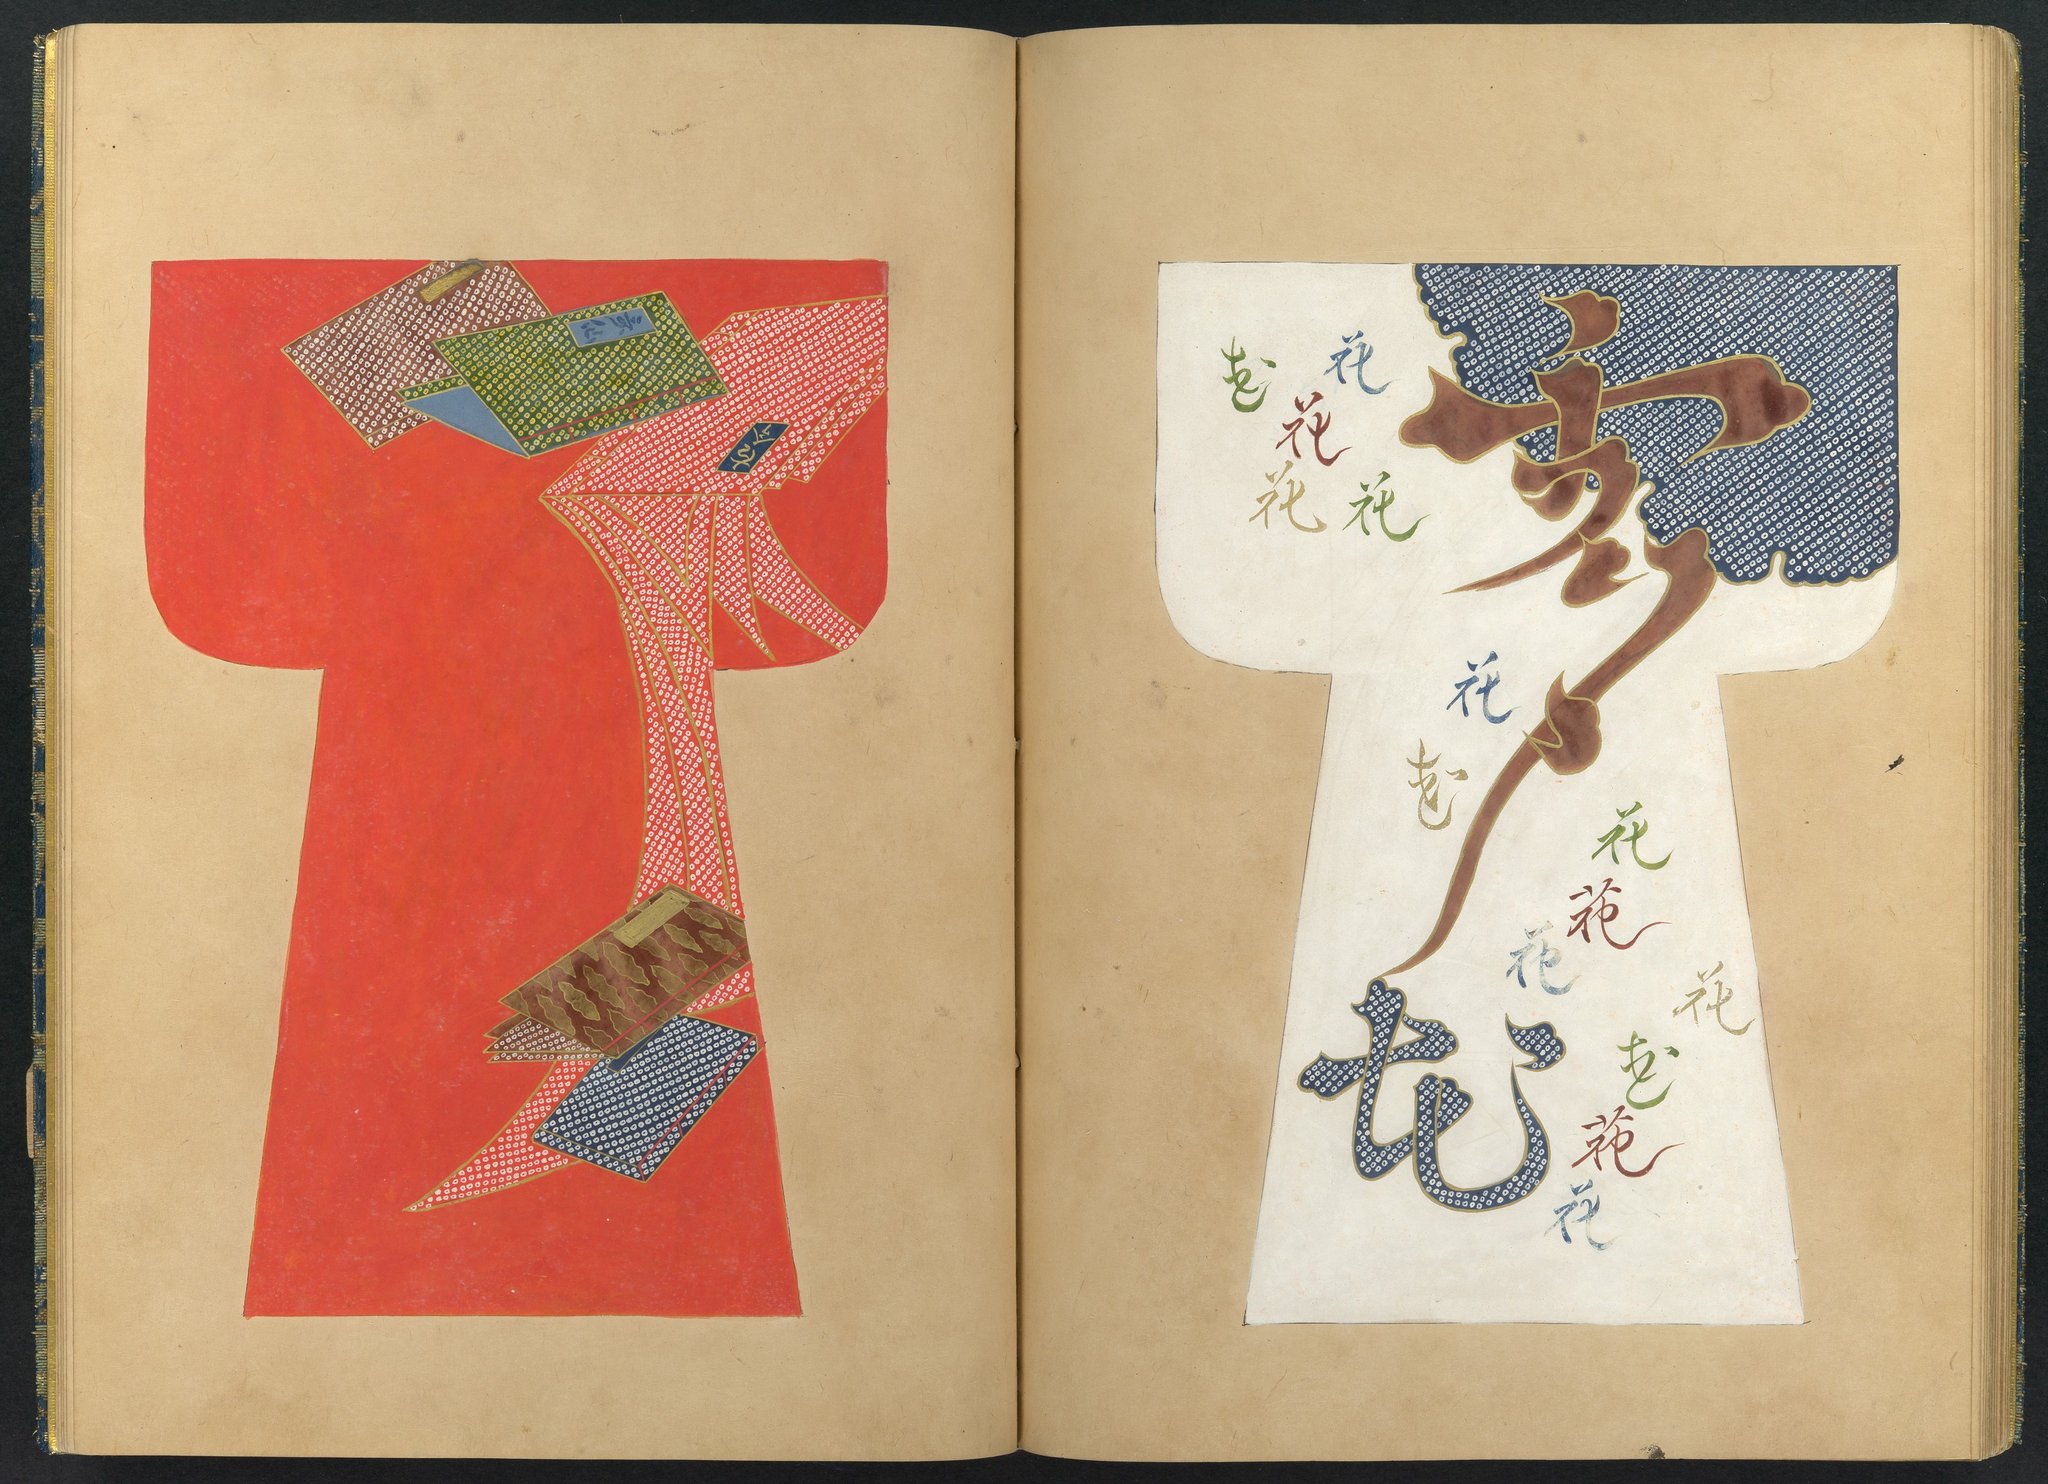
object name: kosode design book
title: Book of Painted Kosode Patterns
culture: japanese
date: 1651-1700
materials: gold, ink, paper, silver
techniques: painting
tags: robes